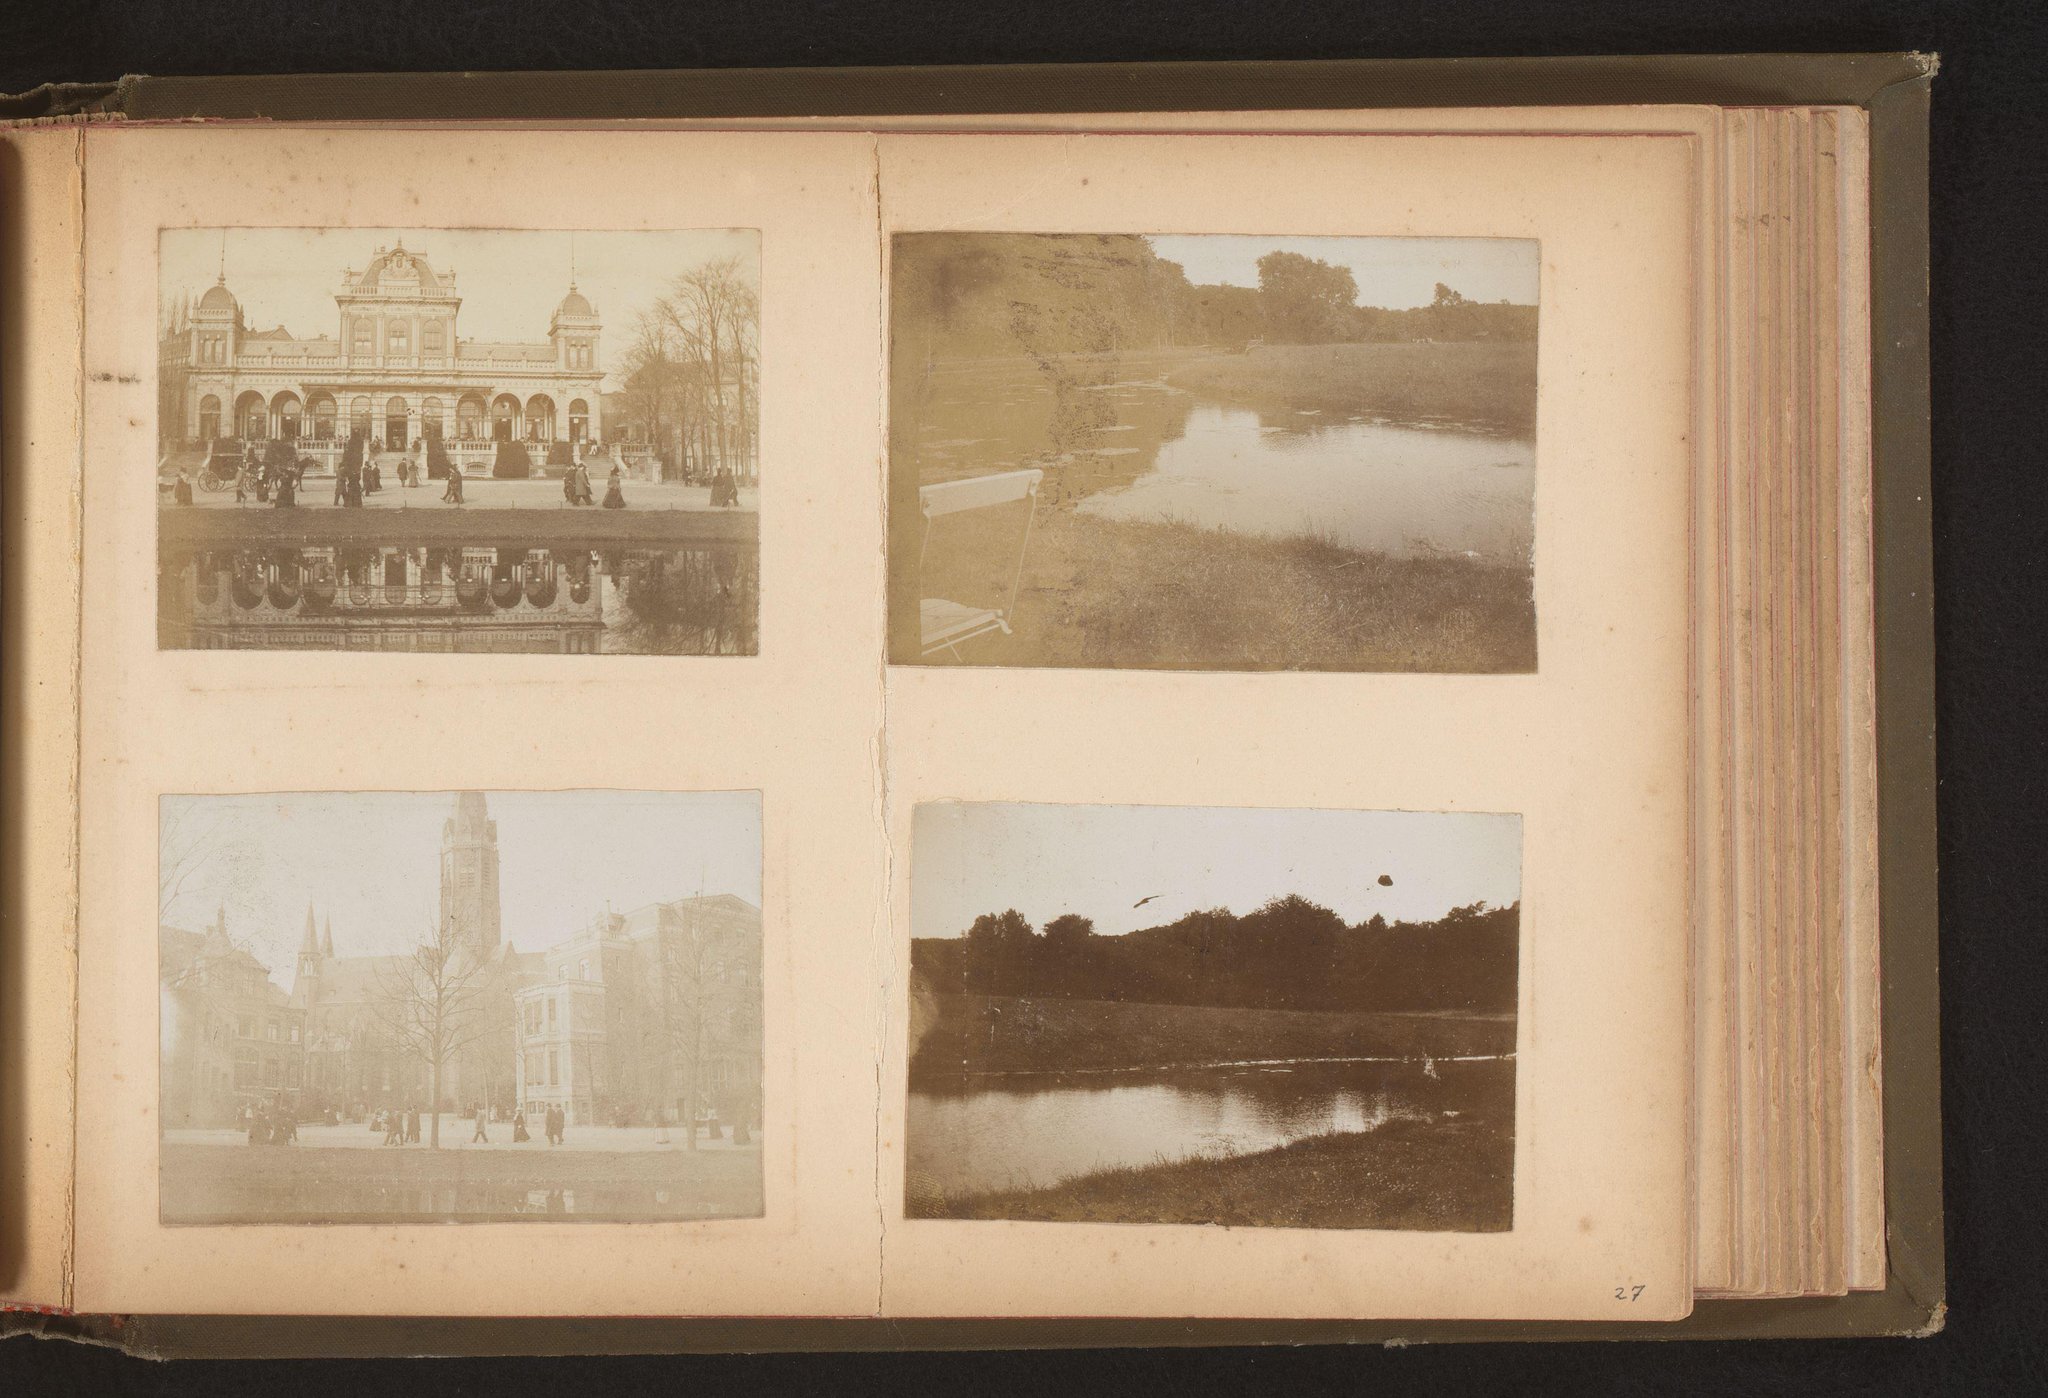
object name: photograph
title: Vier foto's van het Vondelpark, Amsterdam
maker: Anonymous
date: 1895-1910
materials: paper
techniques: albumen print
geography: amsterdam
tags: church (exterior), public gardens, park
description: Deze foto's maken deel uit van een album.